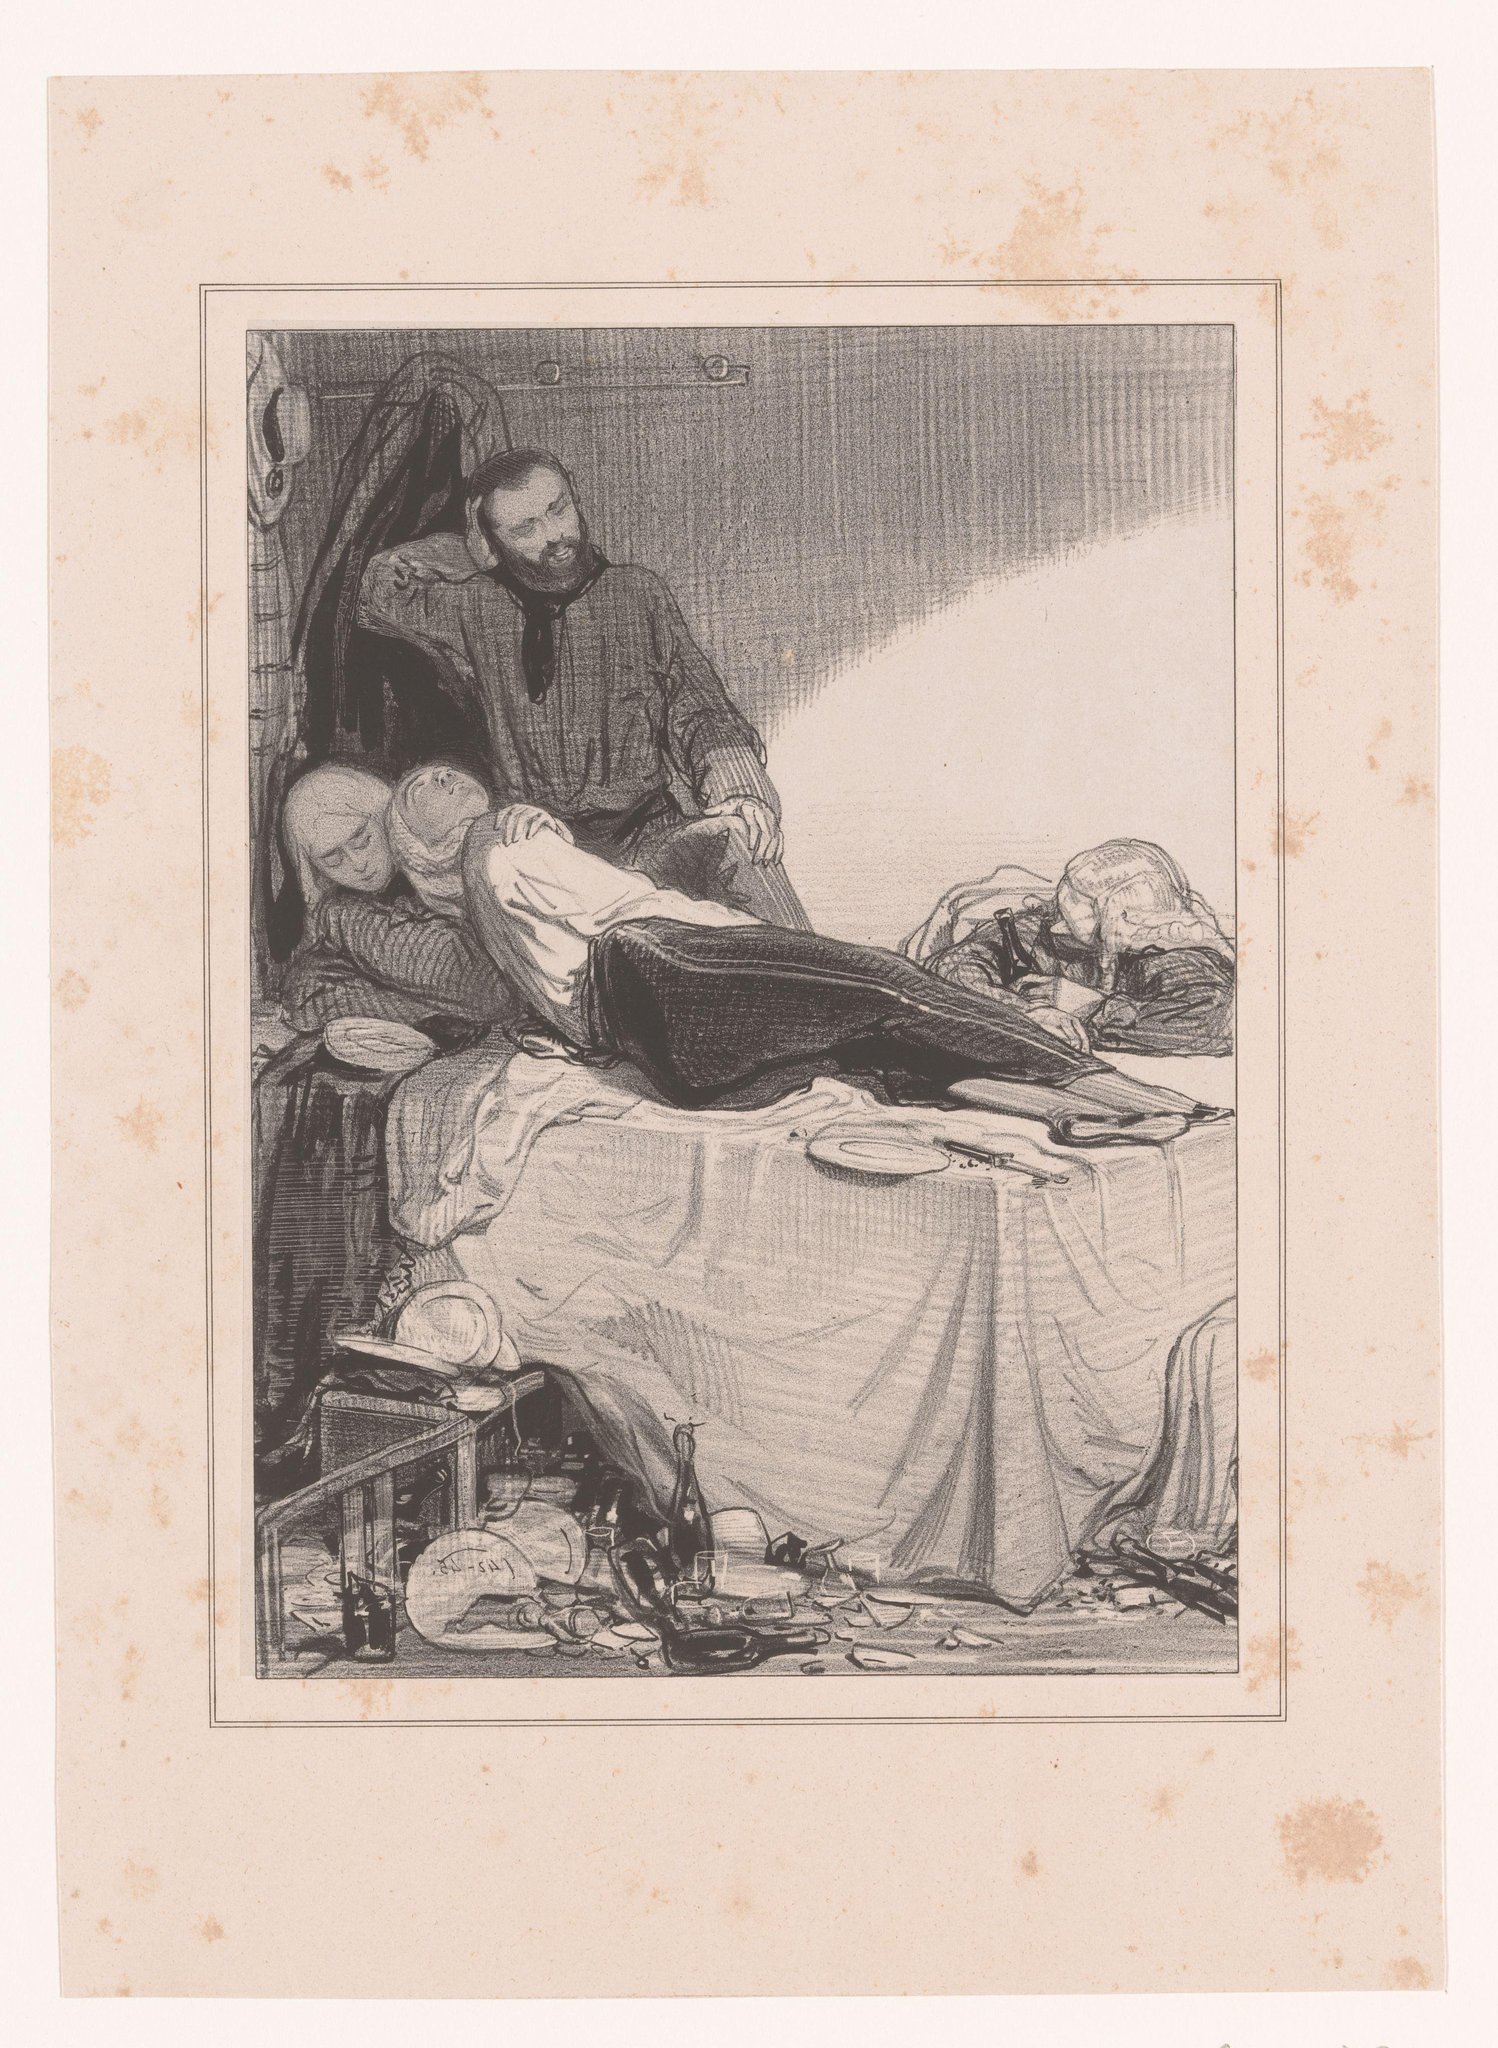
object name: cartoon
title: Ochtend na carnaval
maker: paul gavarni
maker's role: draughtsman, print maker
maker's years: 1804-1866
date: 1843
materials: paper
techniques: lithograph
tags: intoxication, carousal, drinking-bout, orgy (+ broken, damaged tableware, etc.), carousal, drinking-bout, orgy (+ lingering at table), carnival, shrovetide (non-liturgical celebration), waking up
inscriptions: collector's mark: Lugt 964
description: Prent gebruikt voor: Le Charivari, 3 januari 1843.